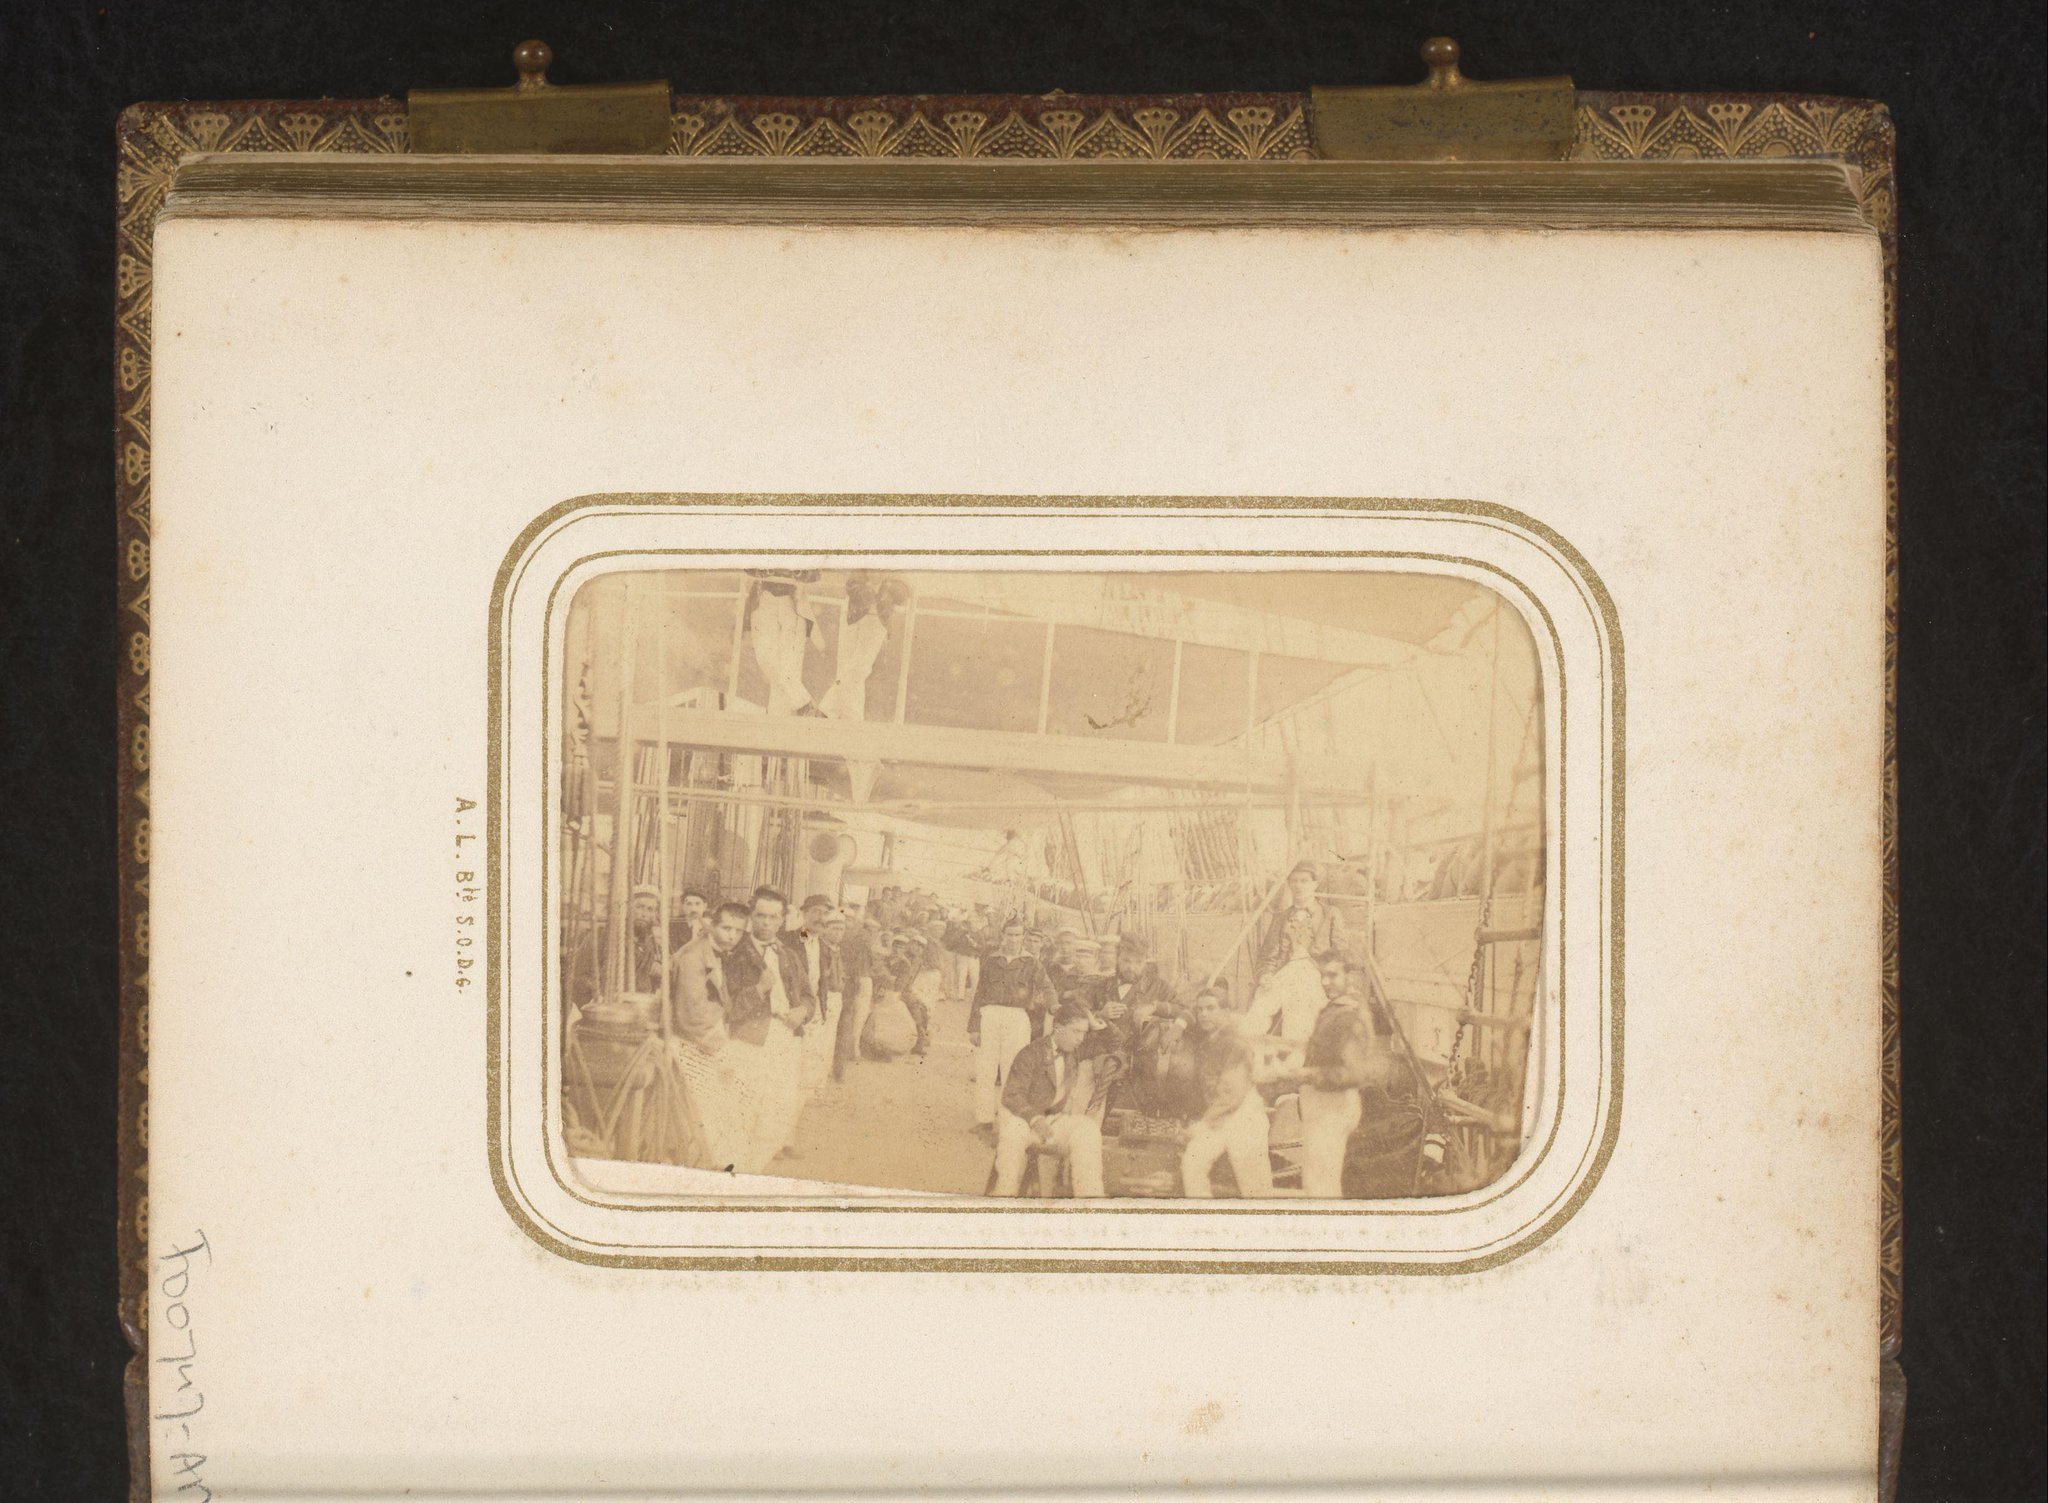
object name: photograph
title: Bemanningsleden aan dek van een schip, staand bij tuigage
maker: marc ferrez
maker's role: fotograaf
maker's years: 1843-1923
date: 1860-1890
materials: cardboard, photographic support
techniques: albumen print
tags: crew ~ ship, parts of ship's exterior: deck, parts of sailing-ship's rigging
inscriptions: inscription: ‘A.L. B.te S.C.D.G.’, inscription: ‘Photographia/ Brazileira/ 96, Rua de S. José, 96/ (Antiga do Parto)/ Rio de Janeiro’